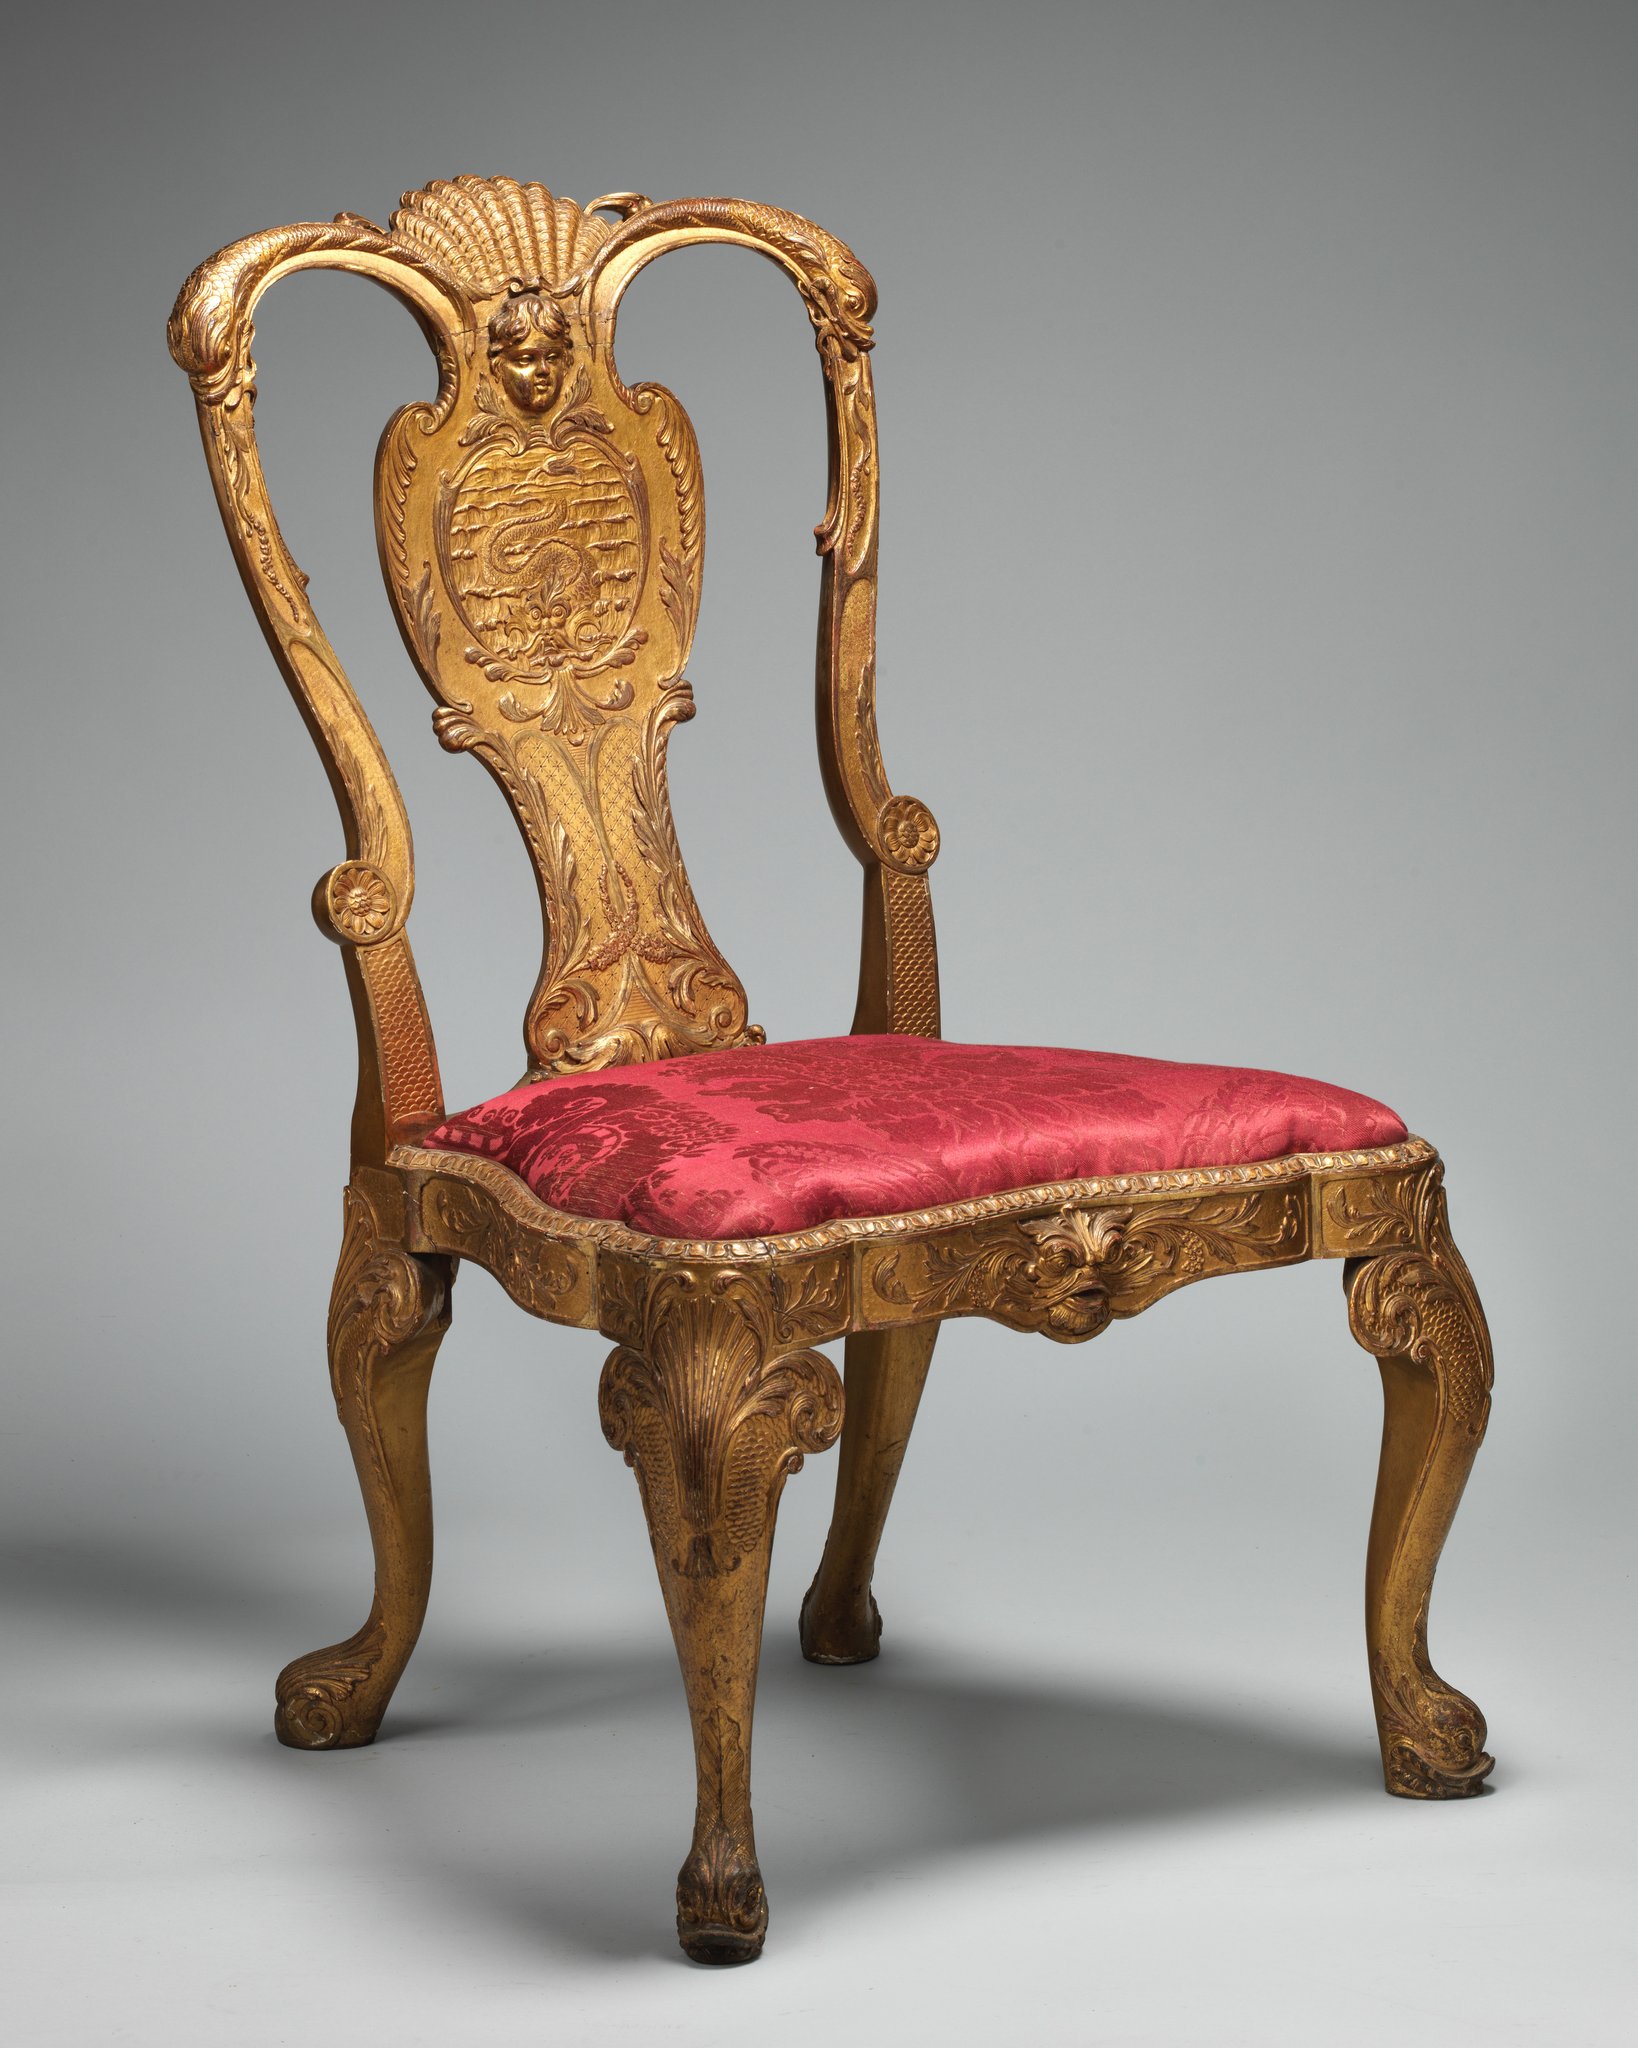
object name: side chair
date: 1725-1735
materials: gesso, wood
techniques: gilding